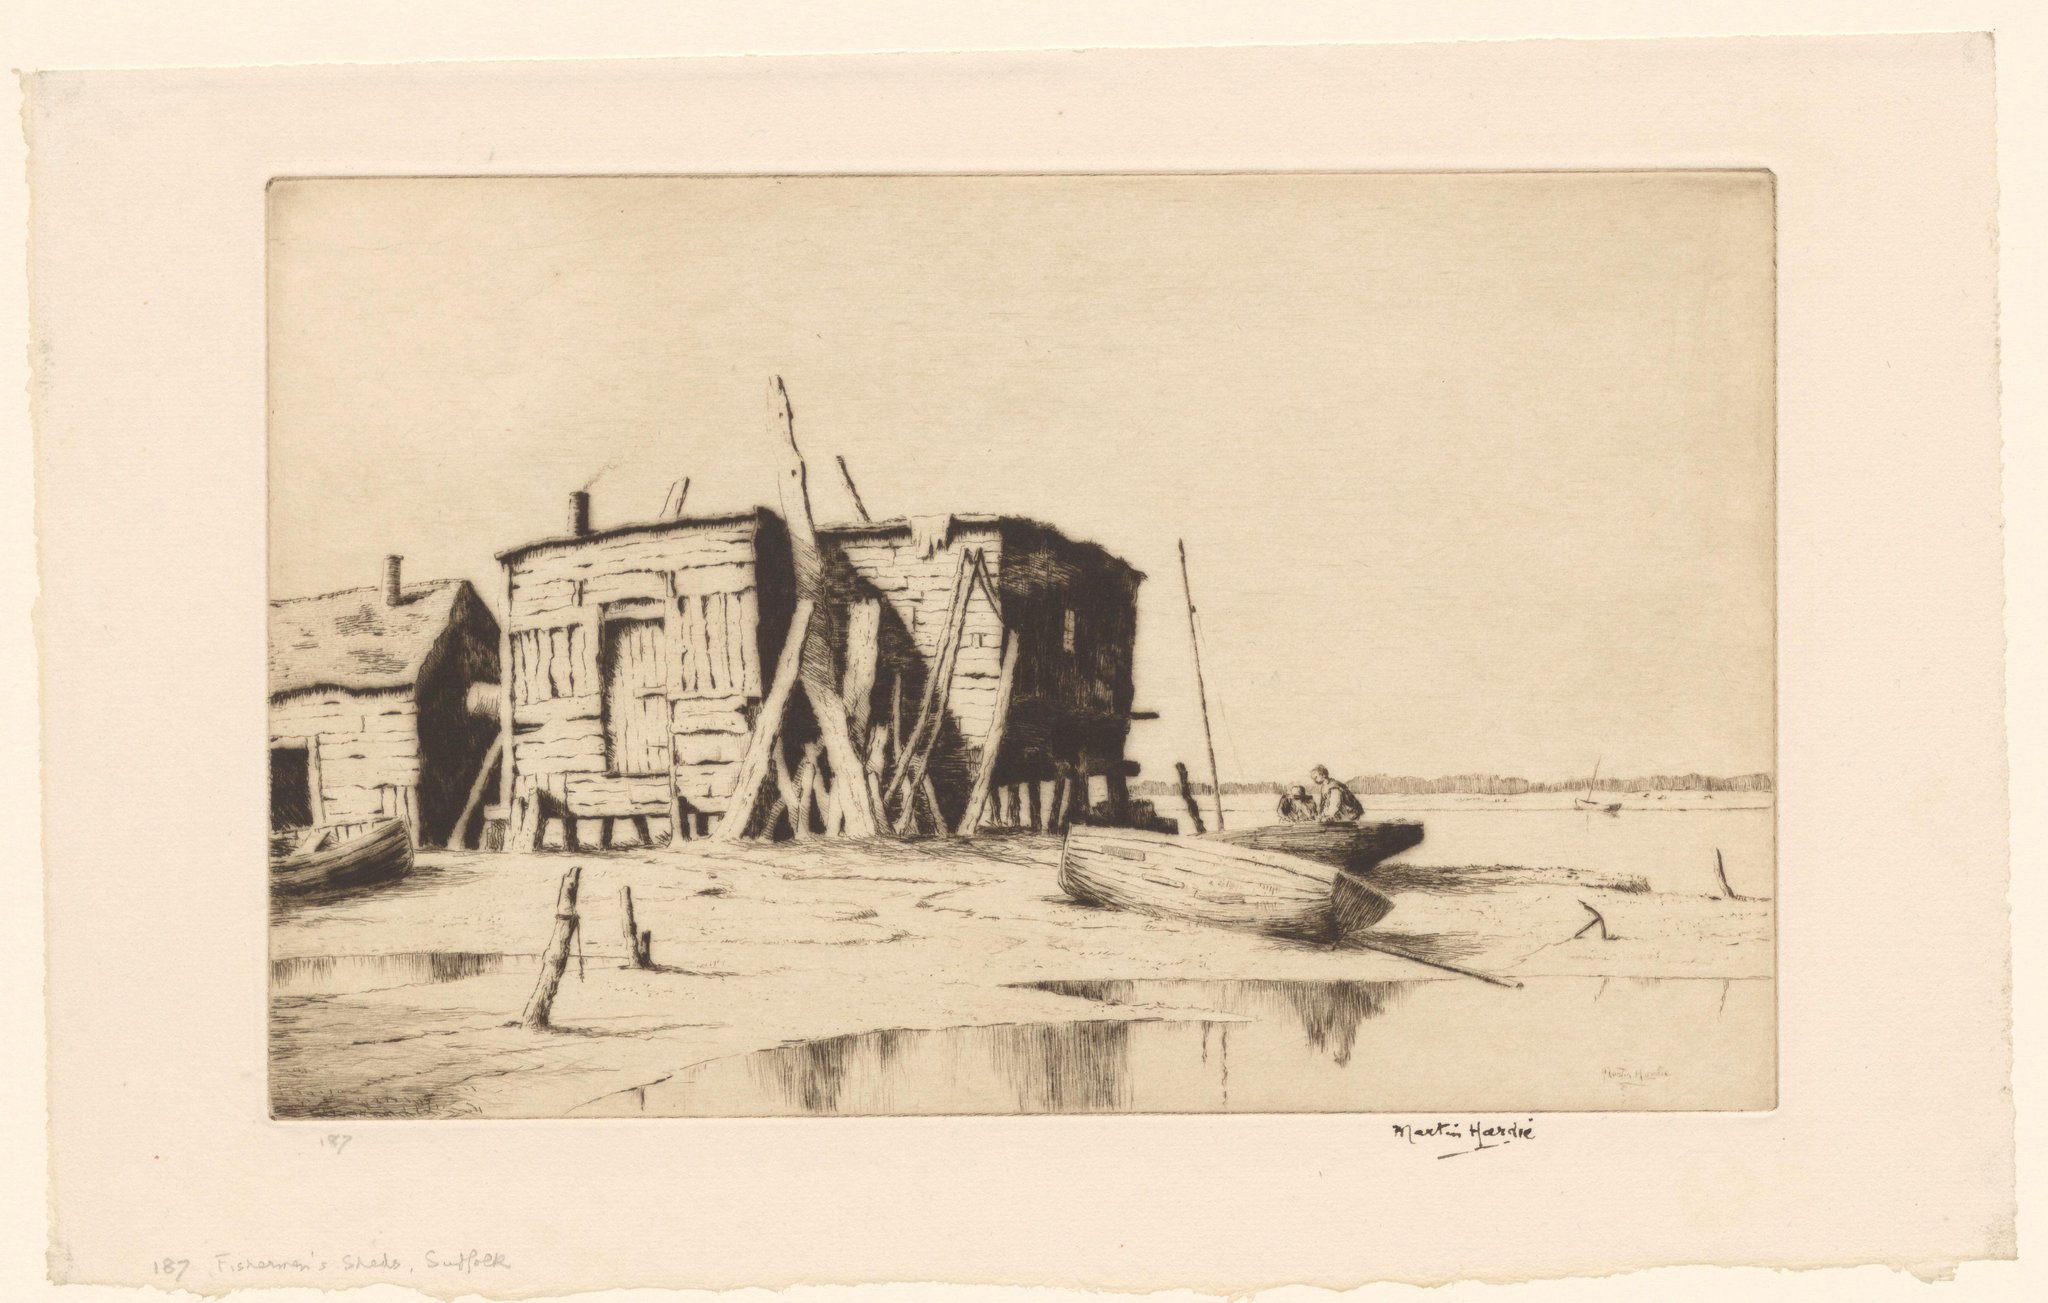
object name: print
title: Fishermen's Sheds, Suffolk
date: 1946-1947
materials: paper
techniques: drypoint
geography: aldeburgh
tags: tow-boat, towing-barge, boat-house, shed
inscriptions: annotation: ‘Martin Hardie’, collector's mark: Lugt 2228, collector's mark: Lugt 2760